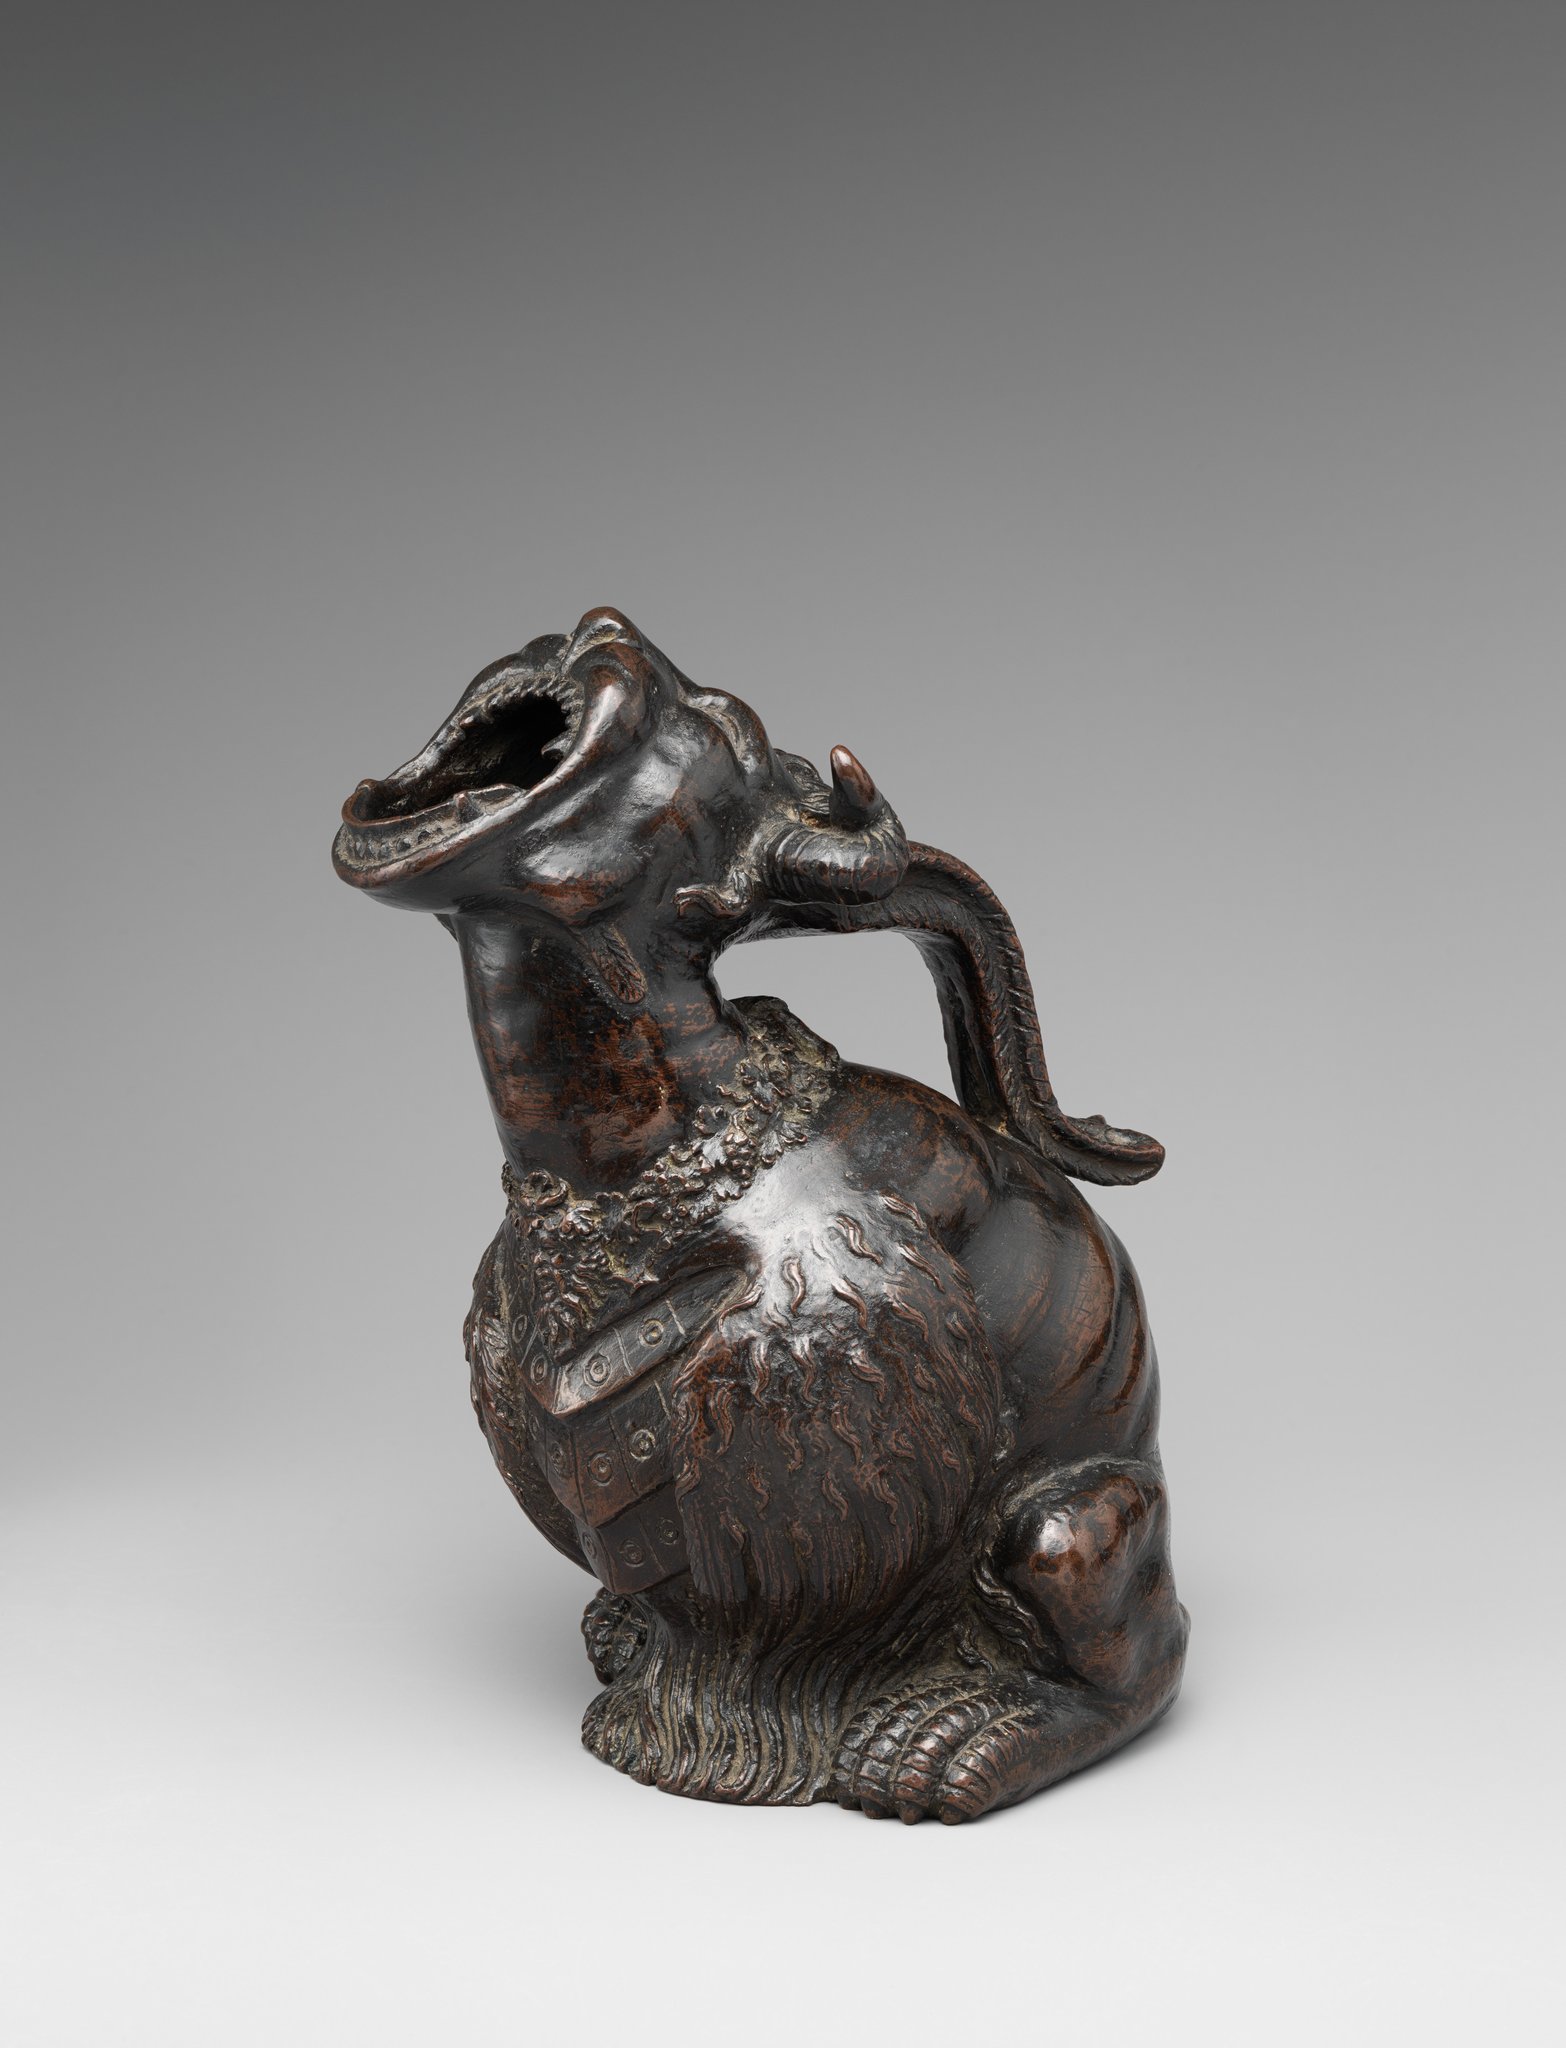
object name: ewer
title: Ewer in the shape of a chimera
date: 1501-1525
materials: bronze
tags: mythical creatures